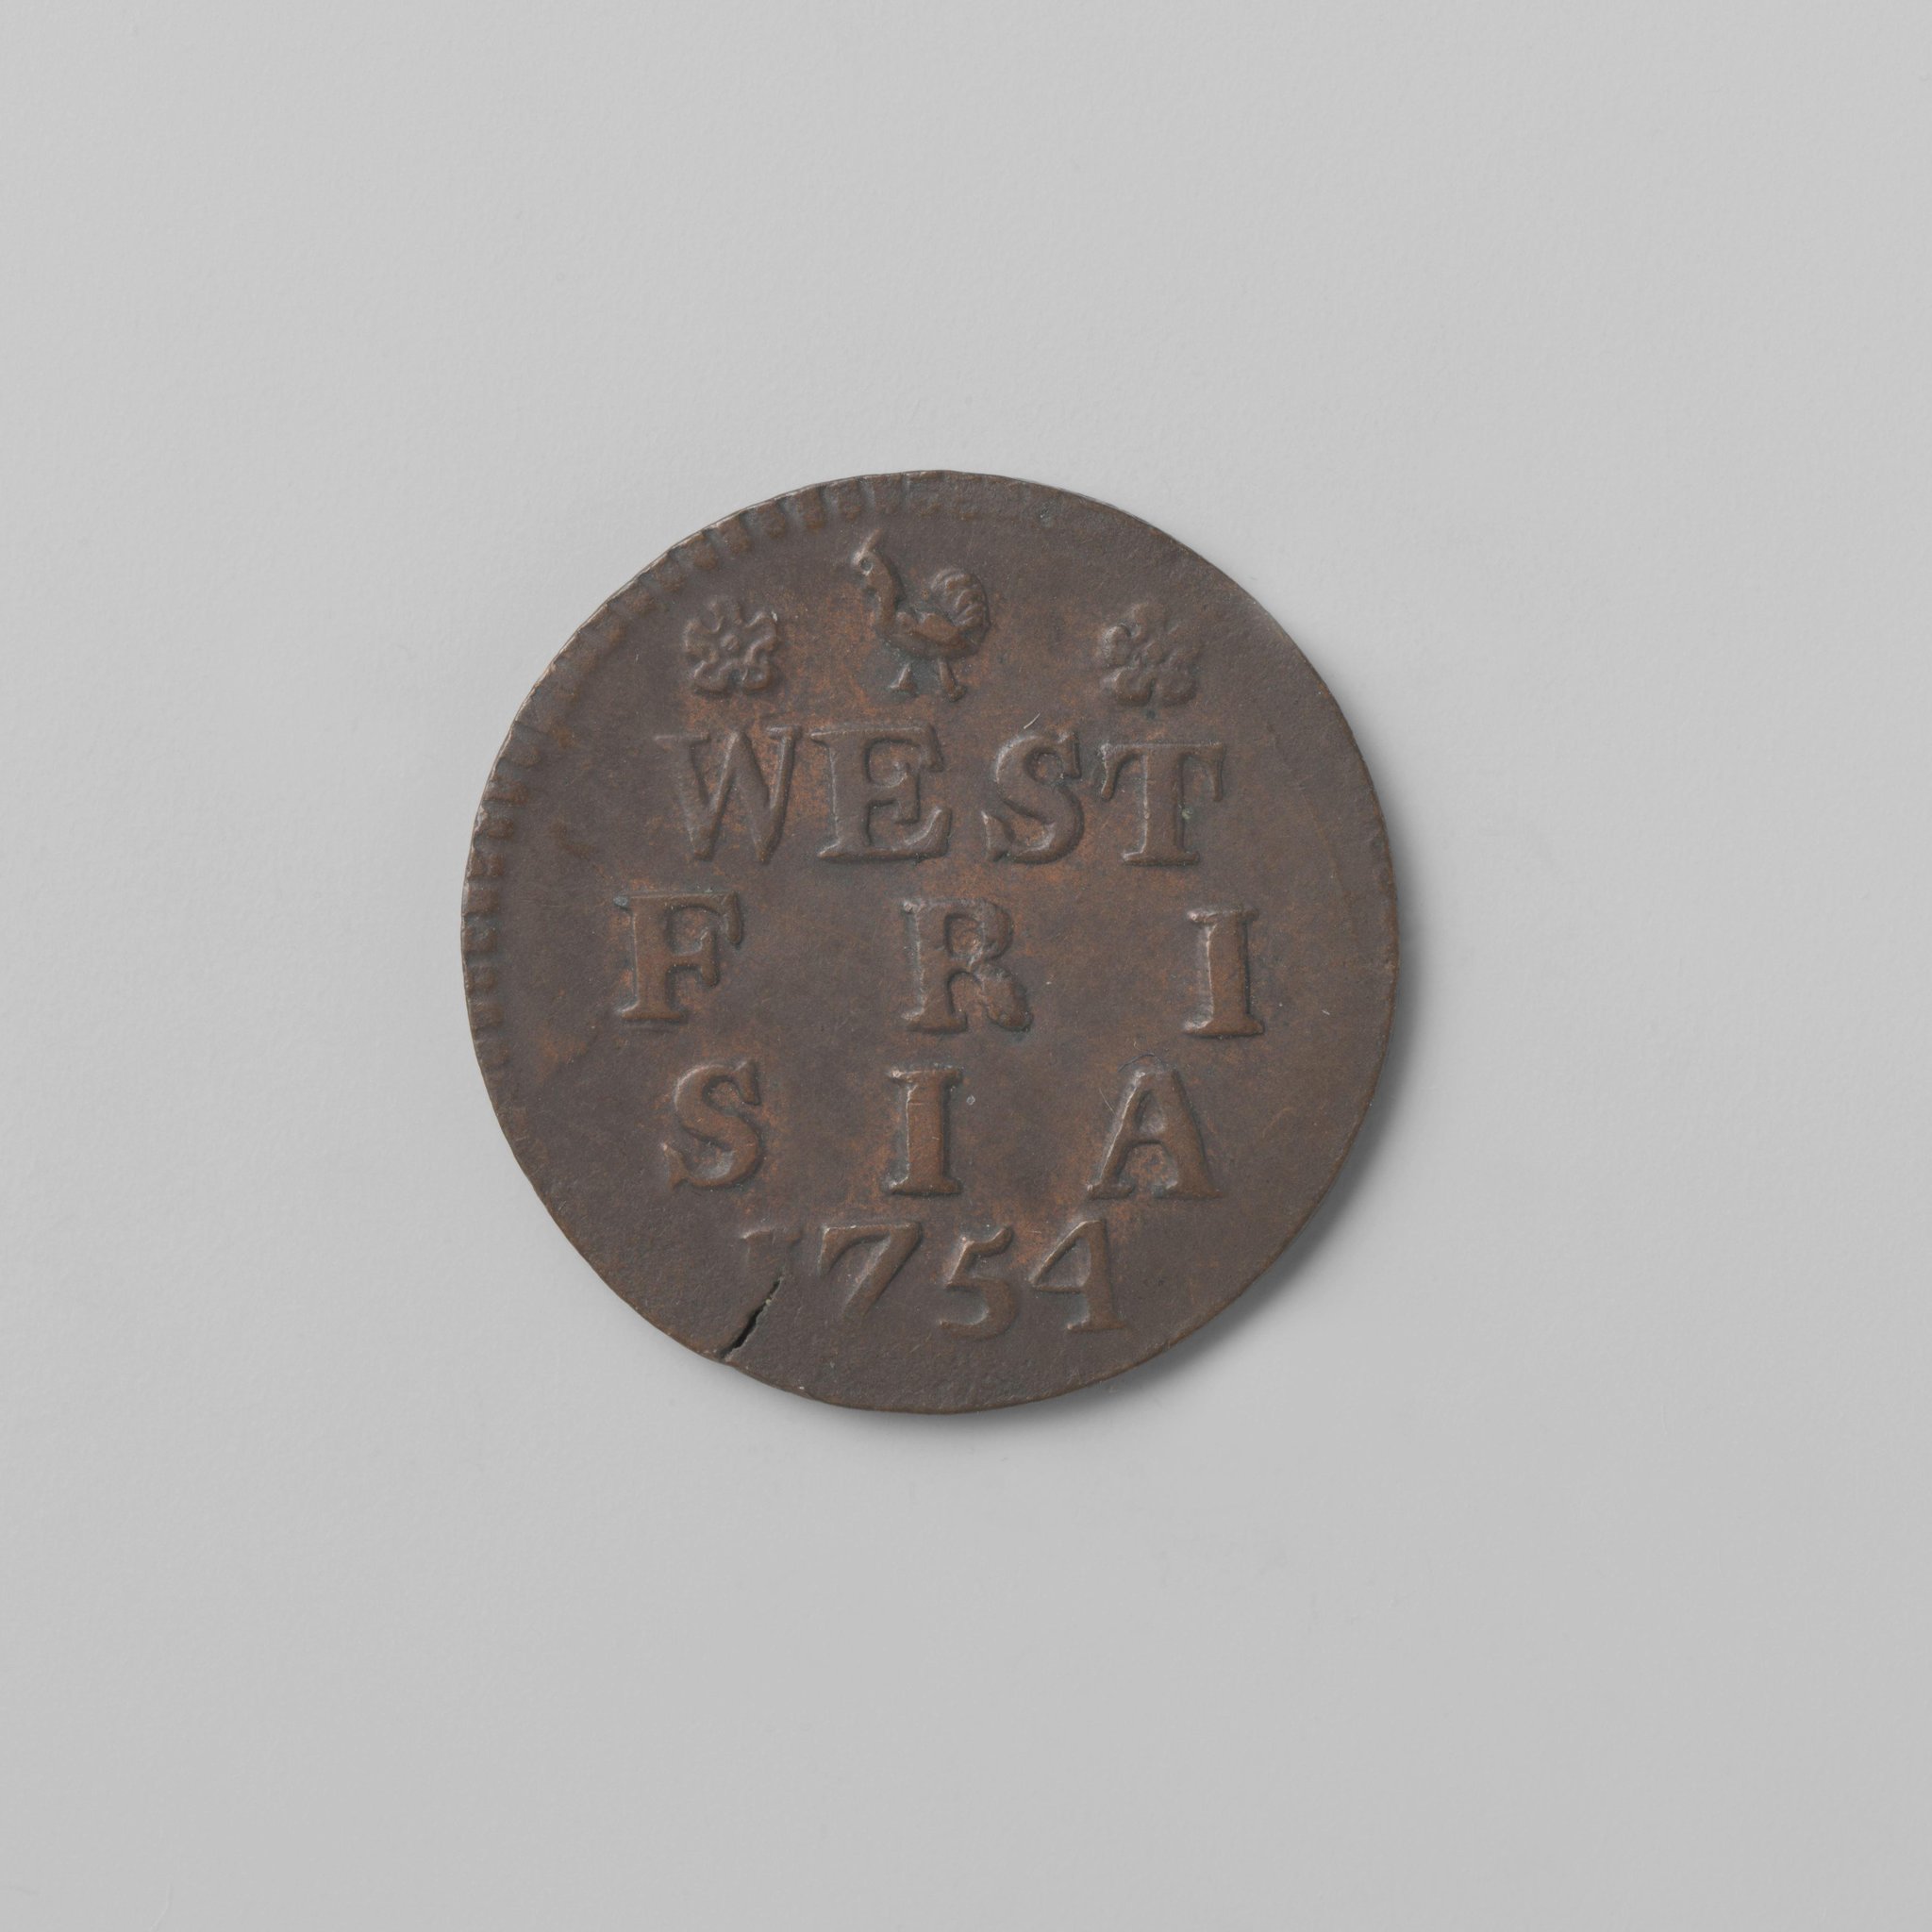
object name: coin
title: Westfriese duit, 1754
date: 1754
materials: copper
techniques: striking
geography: west frisia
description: Koperen munt. Voorzijde: gekroond wapenschild van West-Friesland met lauwertakken. Keerzijde: opschrift in drie regels. Daarboven muntmeesterteken haan tussen twee rozetten. Daaronder jaartal.